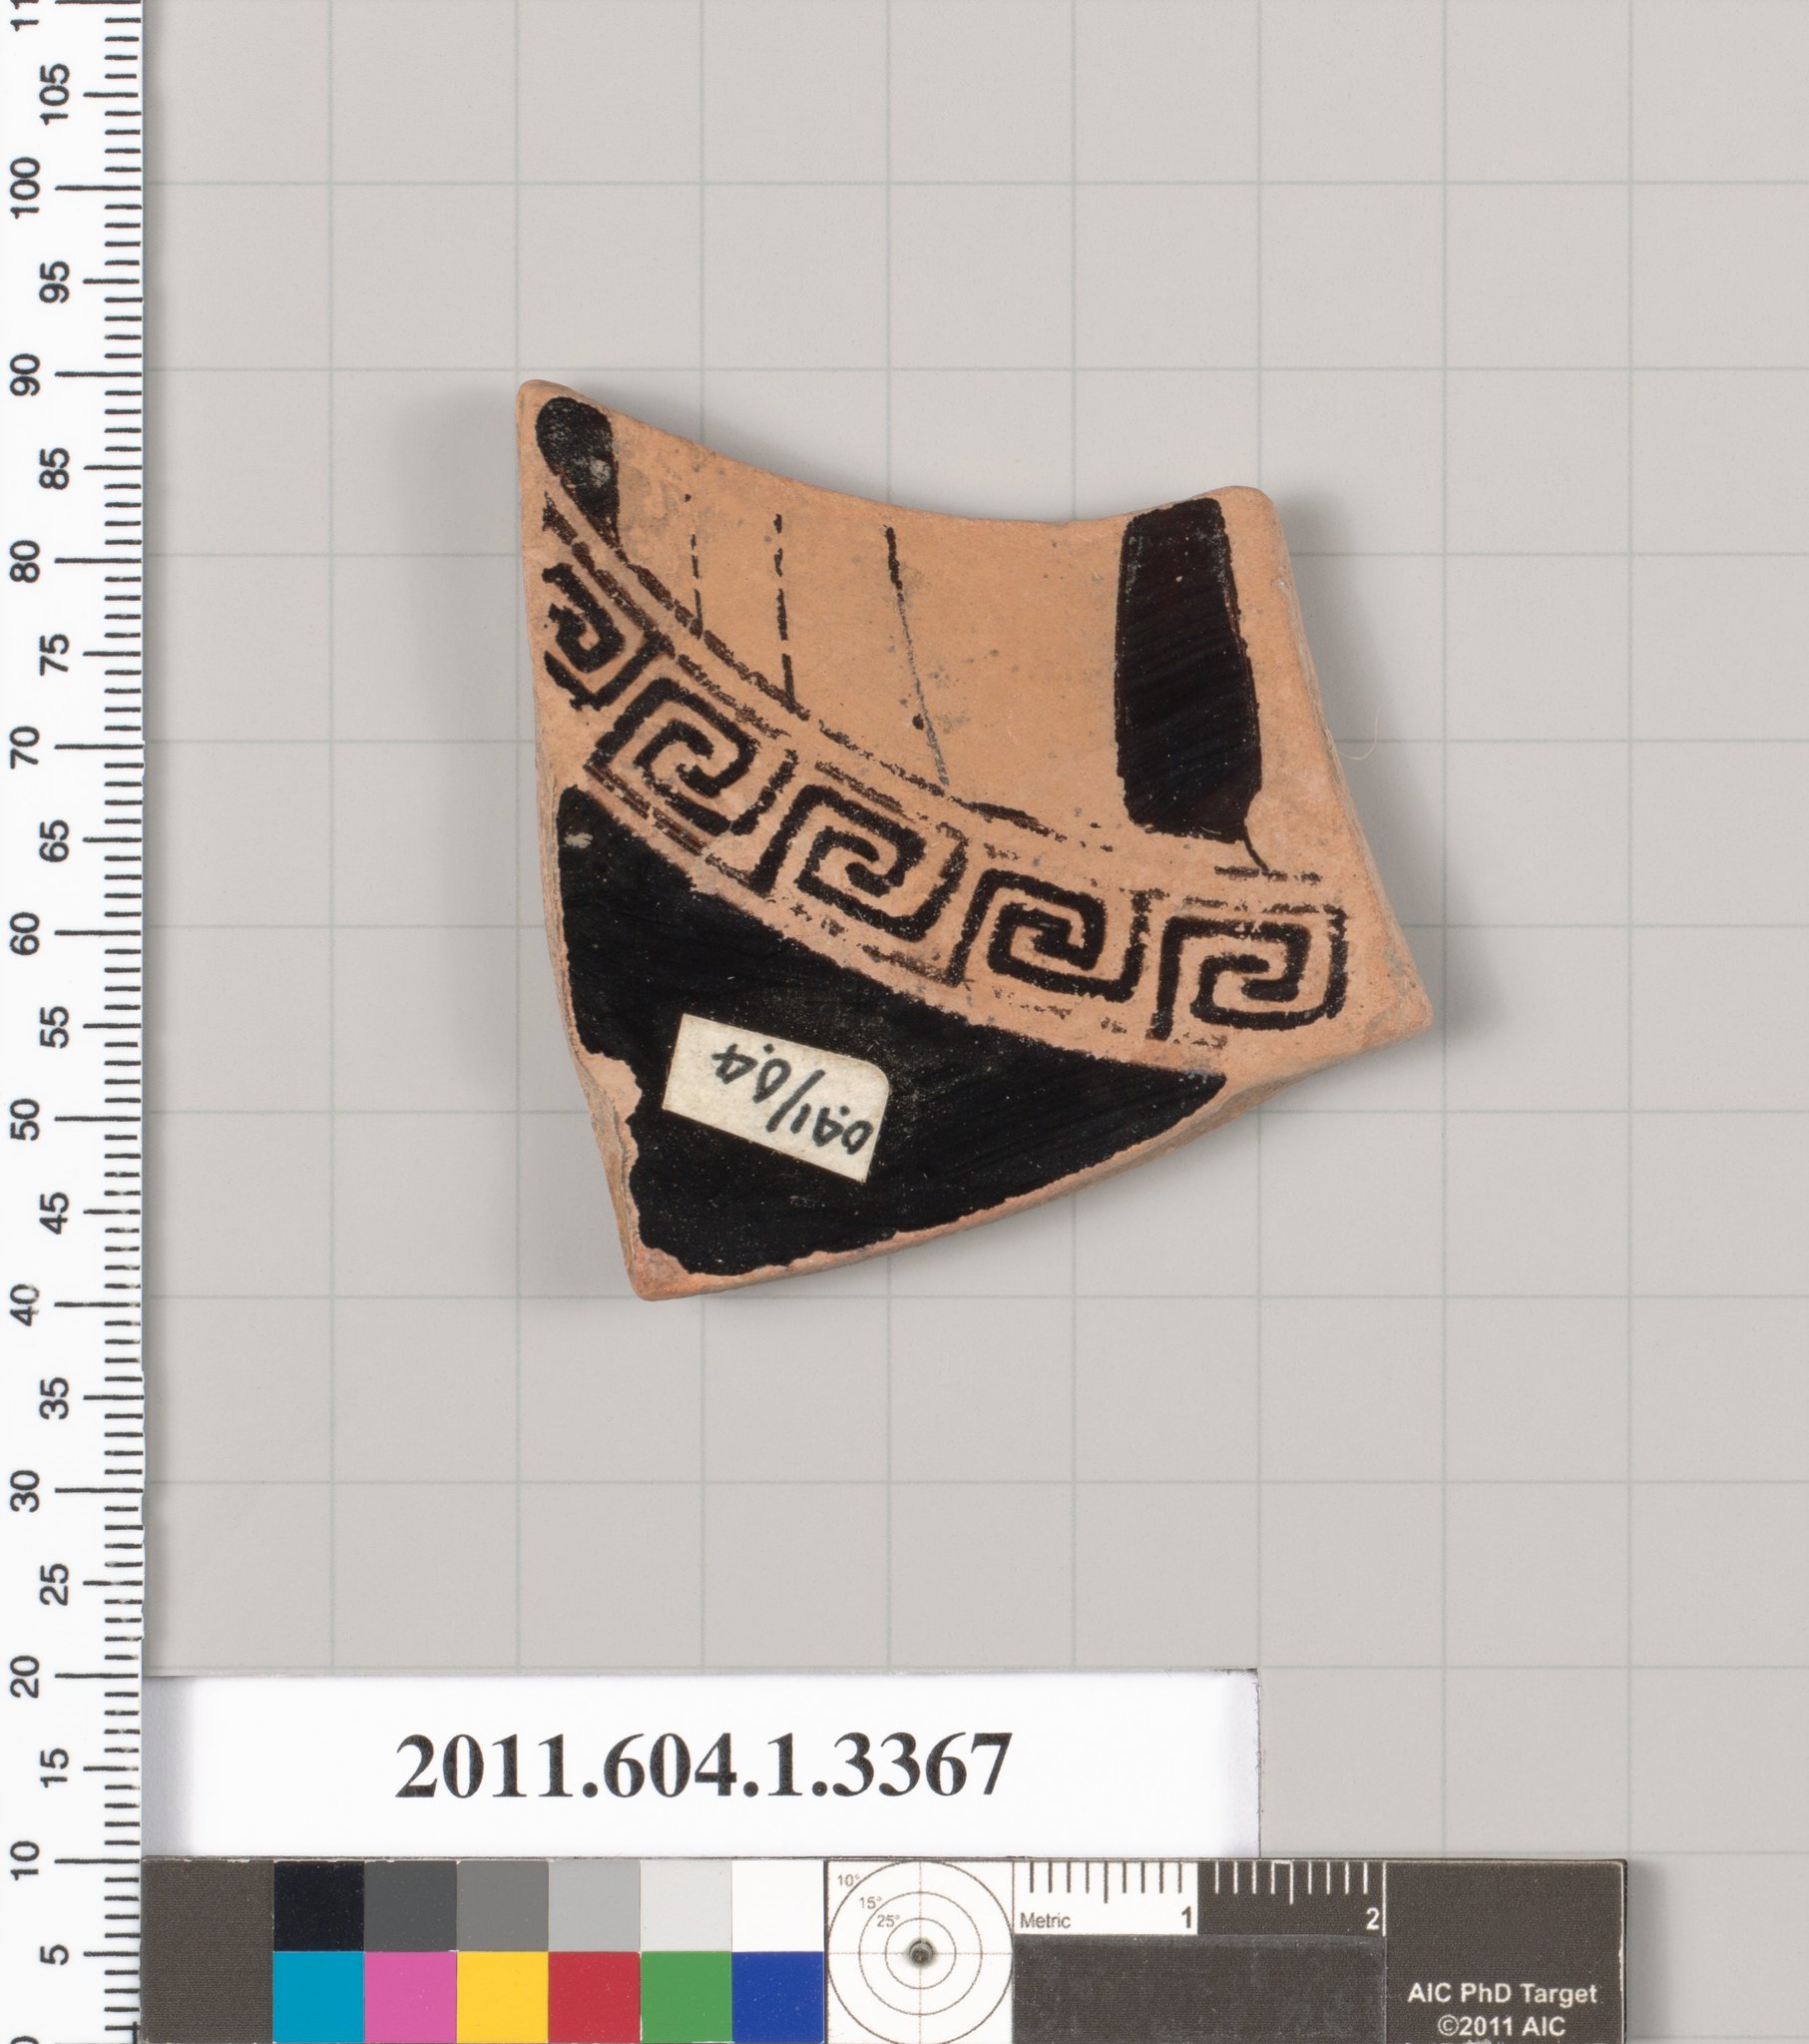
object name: kylix fragment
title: Terracotta fragment of a kylix (drinking cup)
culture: greek, attic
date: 475-451 BCE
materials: terracotta